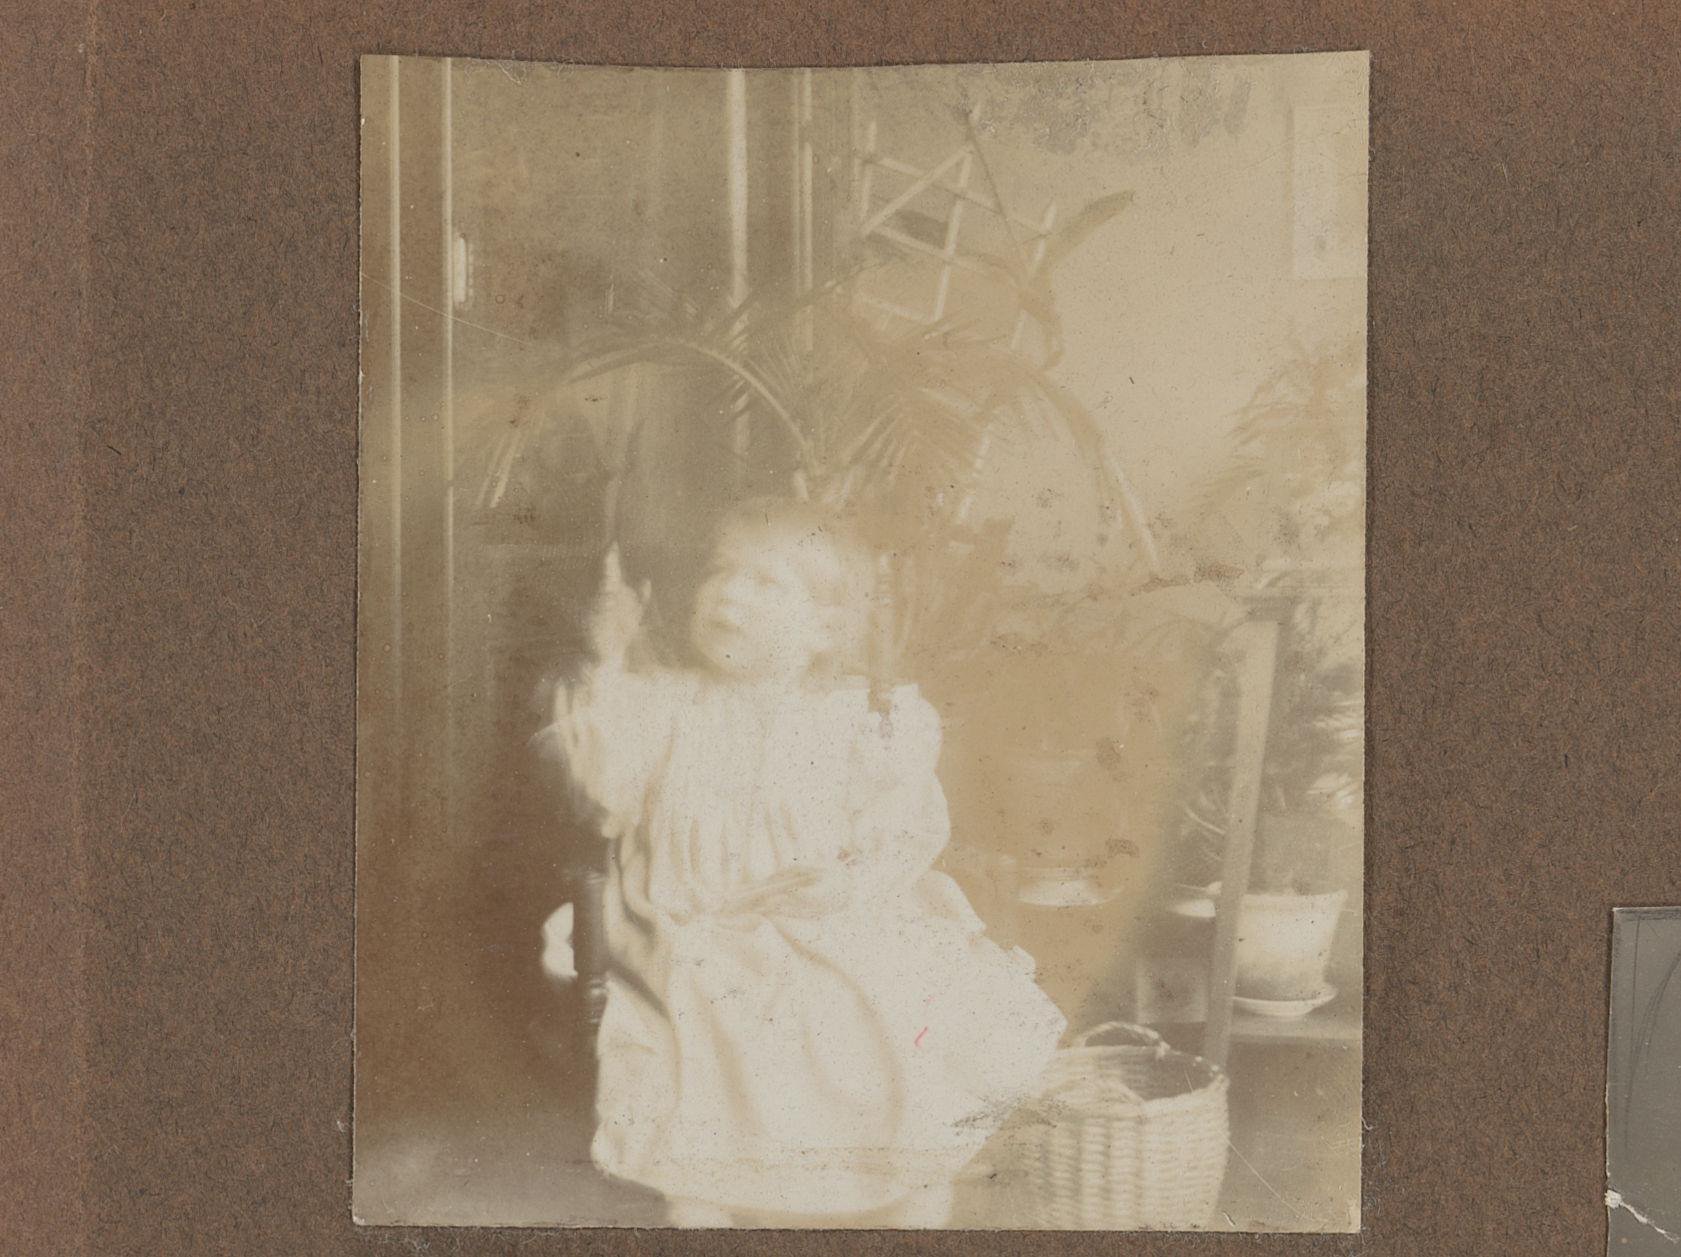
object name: photograph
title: Jong kind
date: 1870-1920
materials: photographic support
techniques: photography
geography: amsterdam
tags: netherlands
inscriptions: inscription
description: Foto op bruin albumblad 43 van familiealbum van Alphons Diepenbrock.